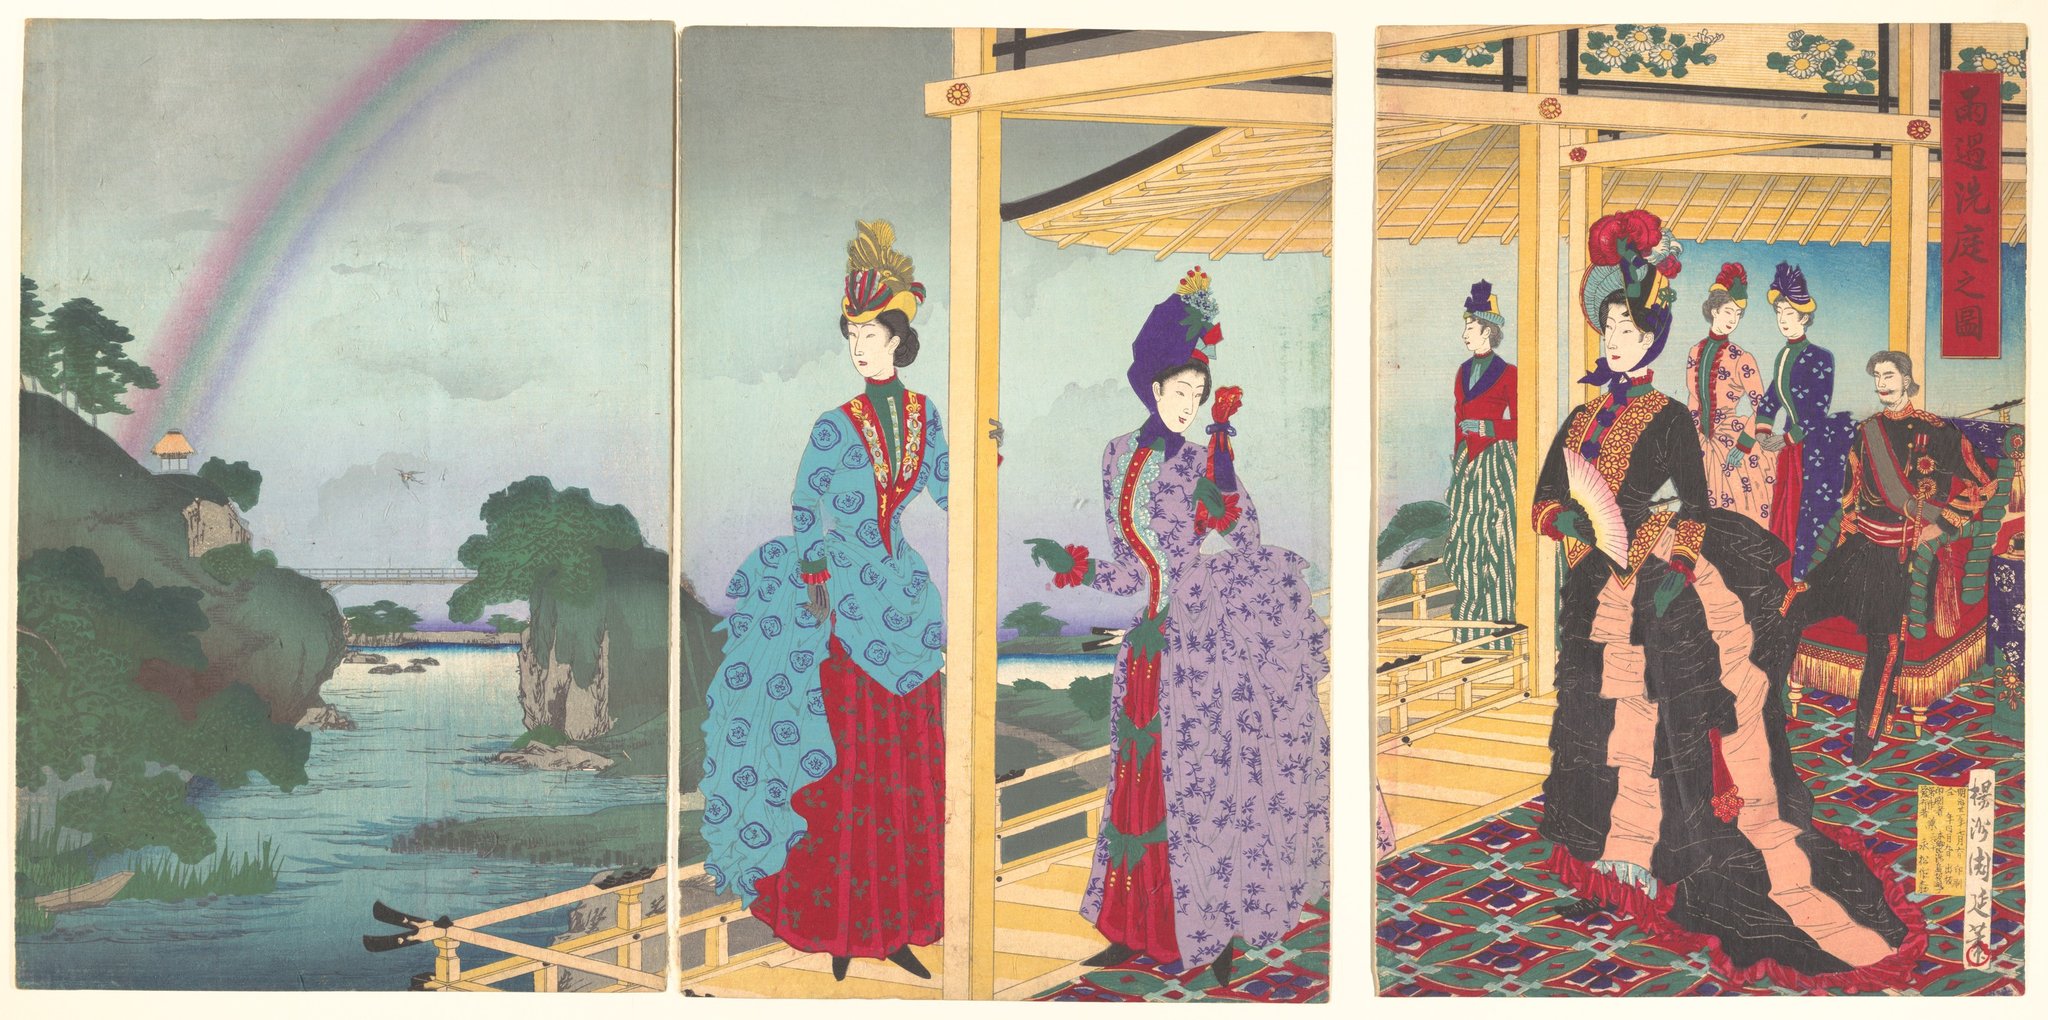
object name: print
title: A Garden Refreshed by the Passing Rain (Ukasentei no zu)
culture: japanese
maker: yōshū (hashimoto) chikanobu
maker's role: artist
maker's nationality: japanese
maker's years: 1838-1912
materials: ink, paper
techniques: woodblock print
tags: men,women,rainbows